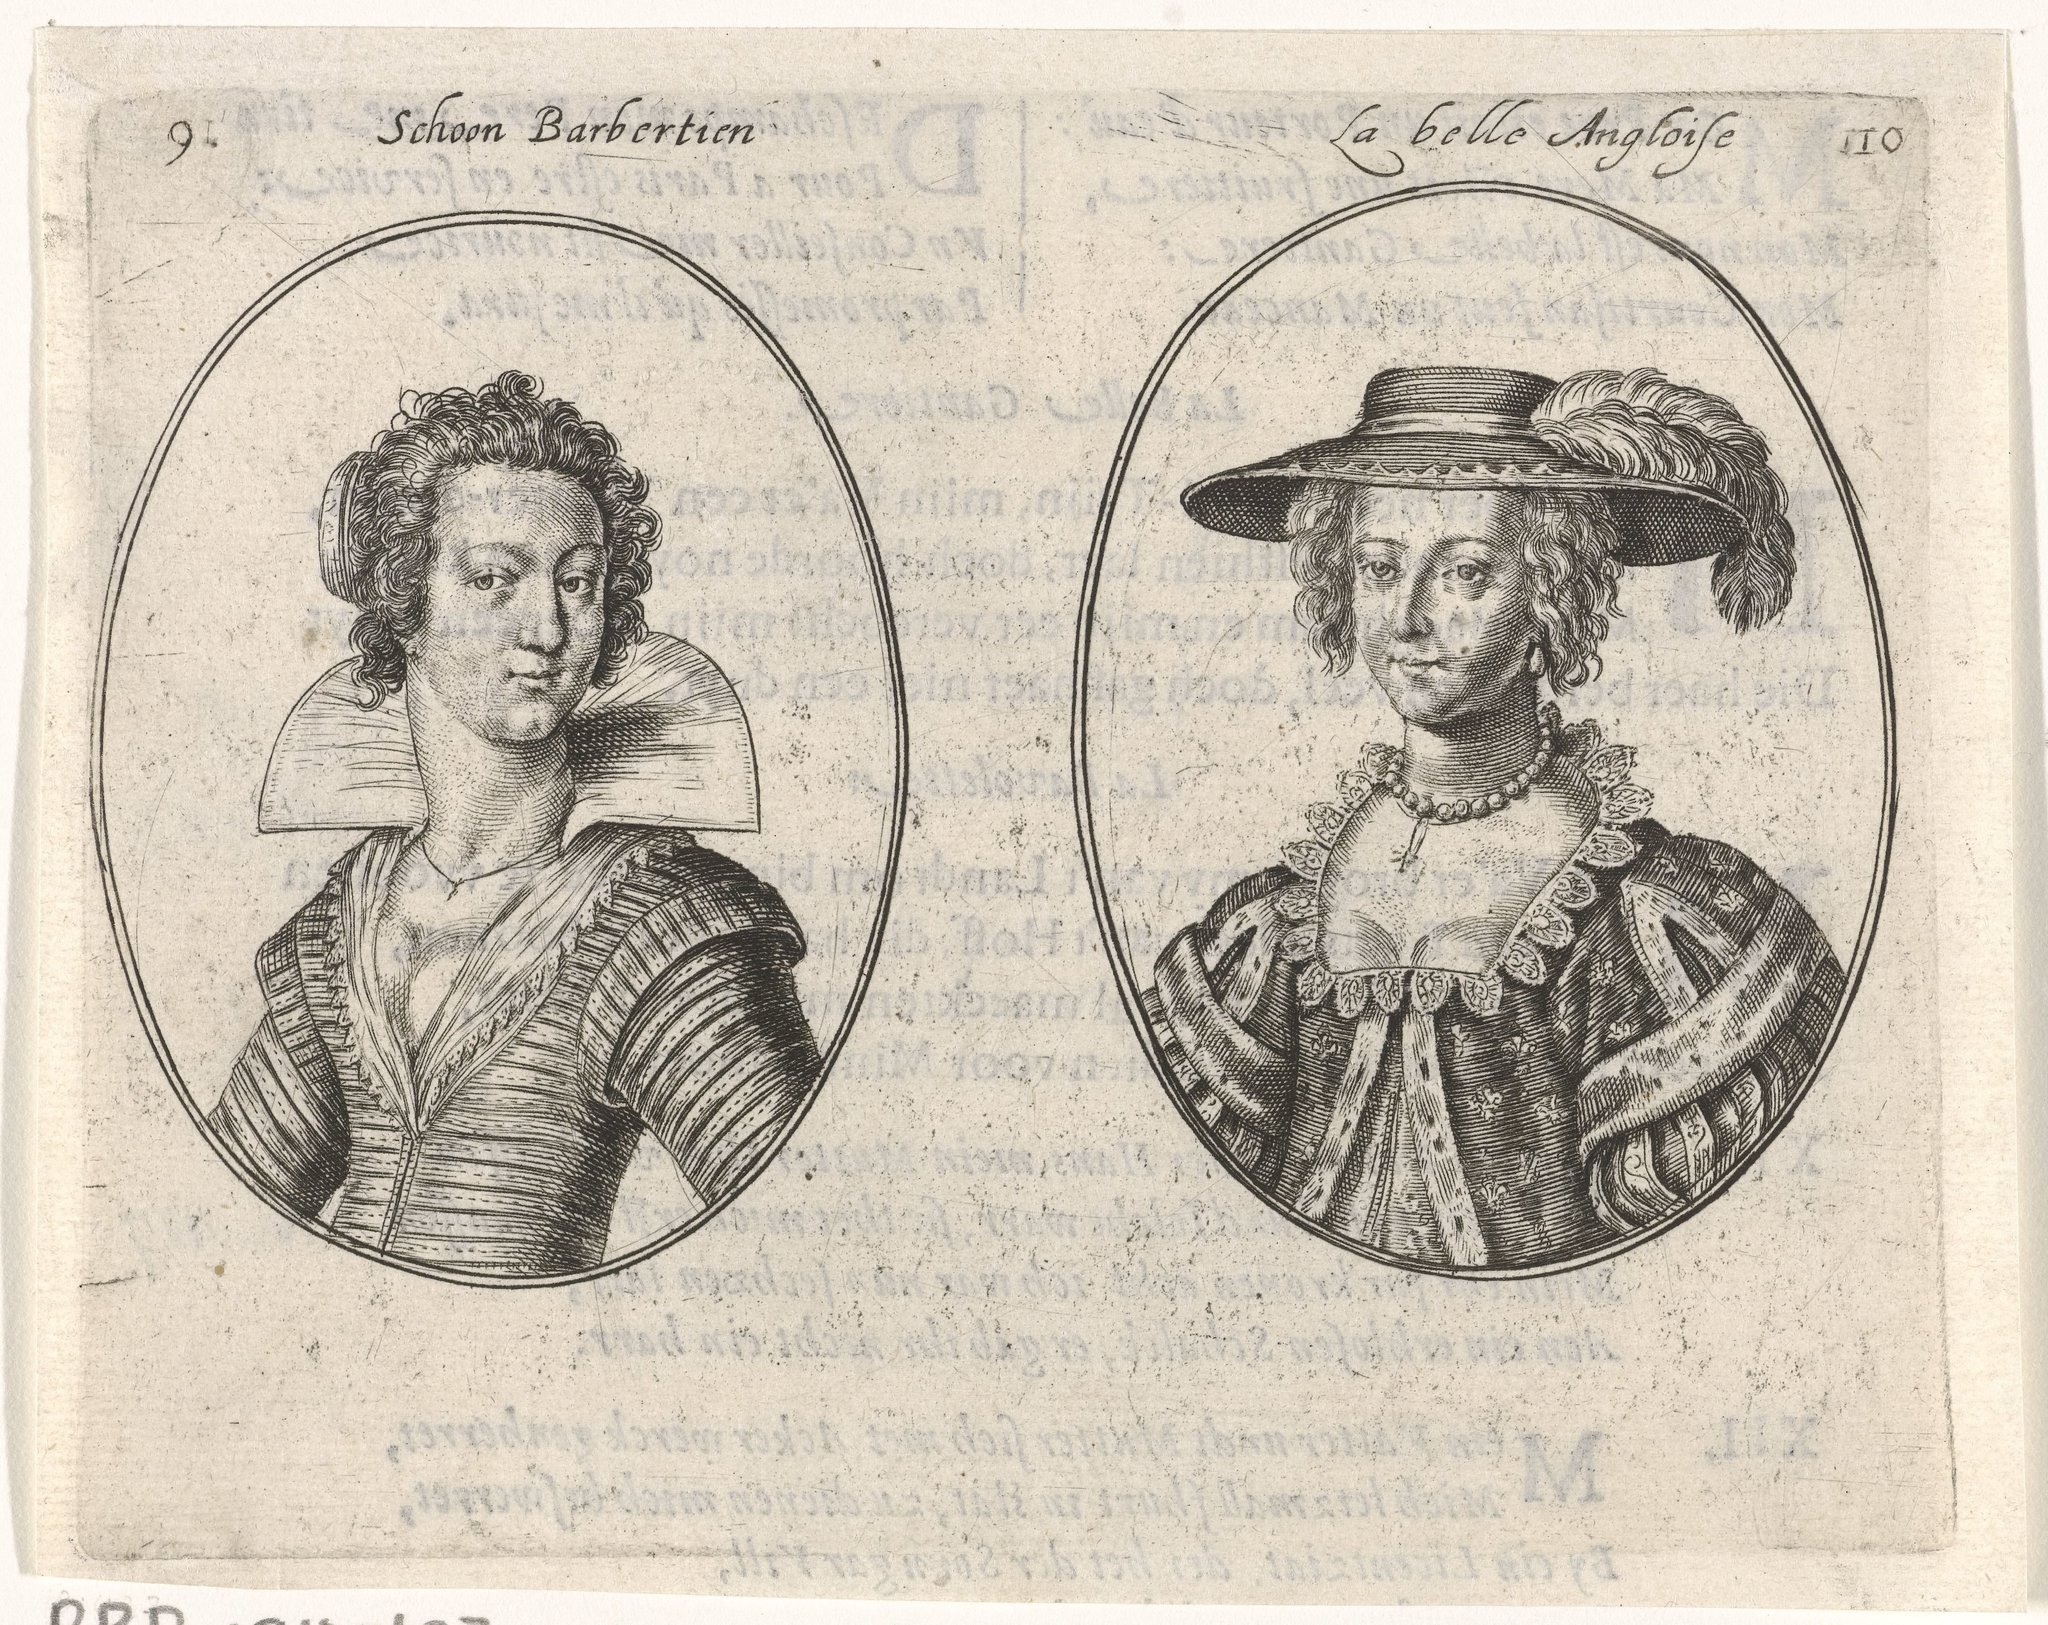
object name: costume print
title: Portretten van twee courtisanes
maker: crispijn van de passe (ii)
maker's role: draughtsman, print maker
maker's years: 1594-1670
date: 1635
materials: paper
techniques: engraving, letterpress printing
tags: whore, prostitute - cc - male prostitution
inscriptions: collector's mark: Lugt 2228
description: Portretten van twee courtisanes die gekleed zijn volgens de mode van hun tijd. In de bovenhoeken genummerd: 9 en 10.